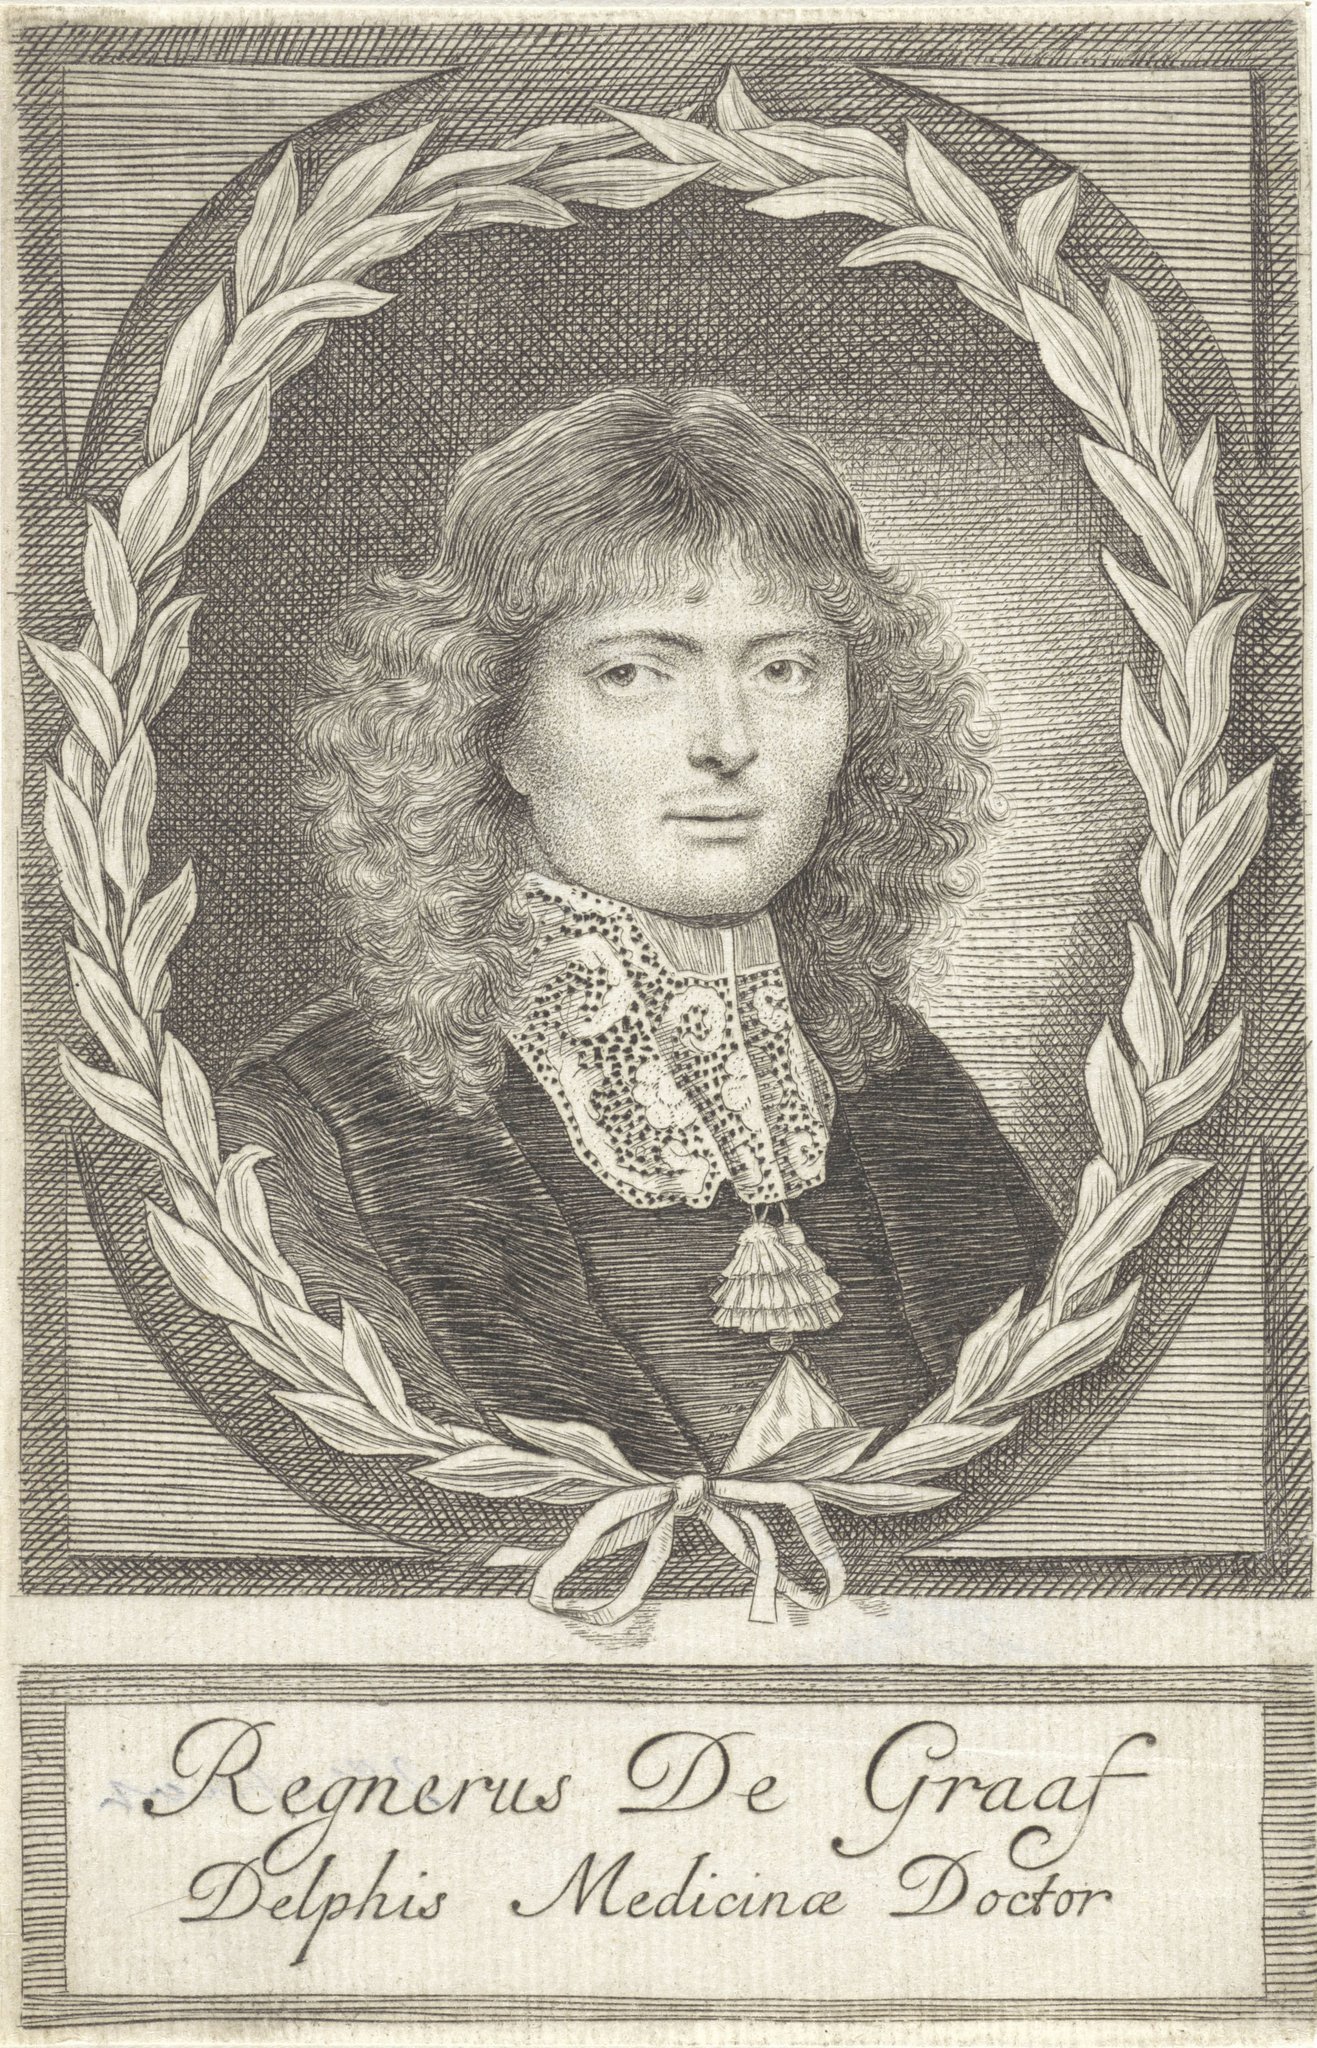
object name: print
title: Portret van Reinier de Graaf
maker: anna maria van schurman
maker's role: draughtsman, print maker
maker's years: 1607-1678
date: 1666-1673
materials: paper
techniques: engraving, etching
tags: delft, reinier de graaf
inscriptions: collector's mark: Lugt 2228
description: Portret van de arts en anatoom Reinier de Graaf.